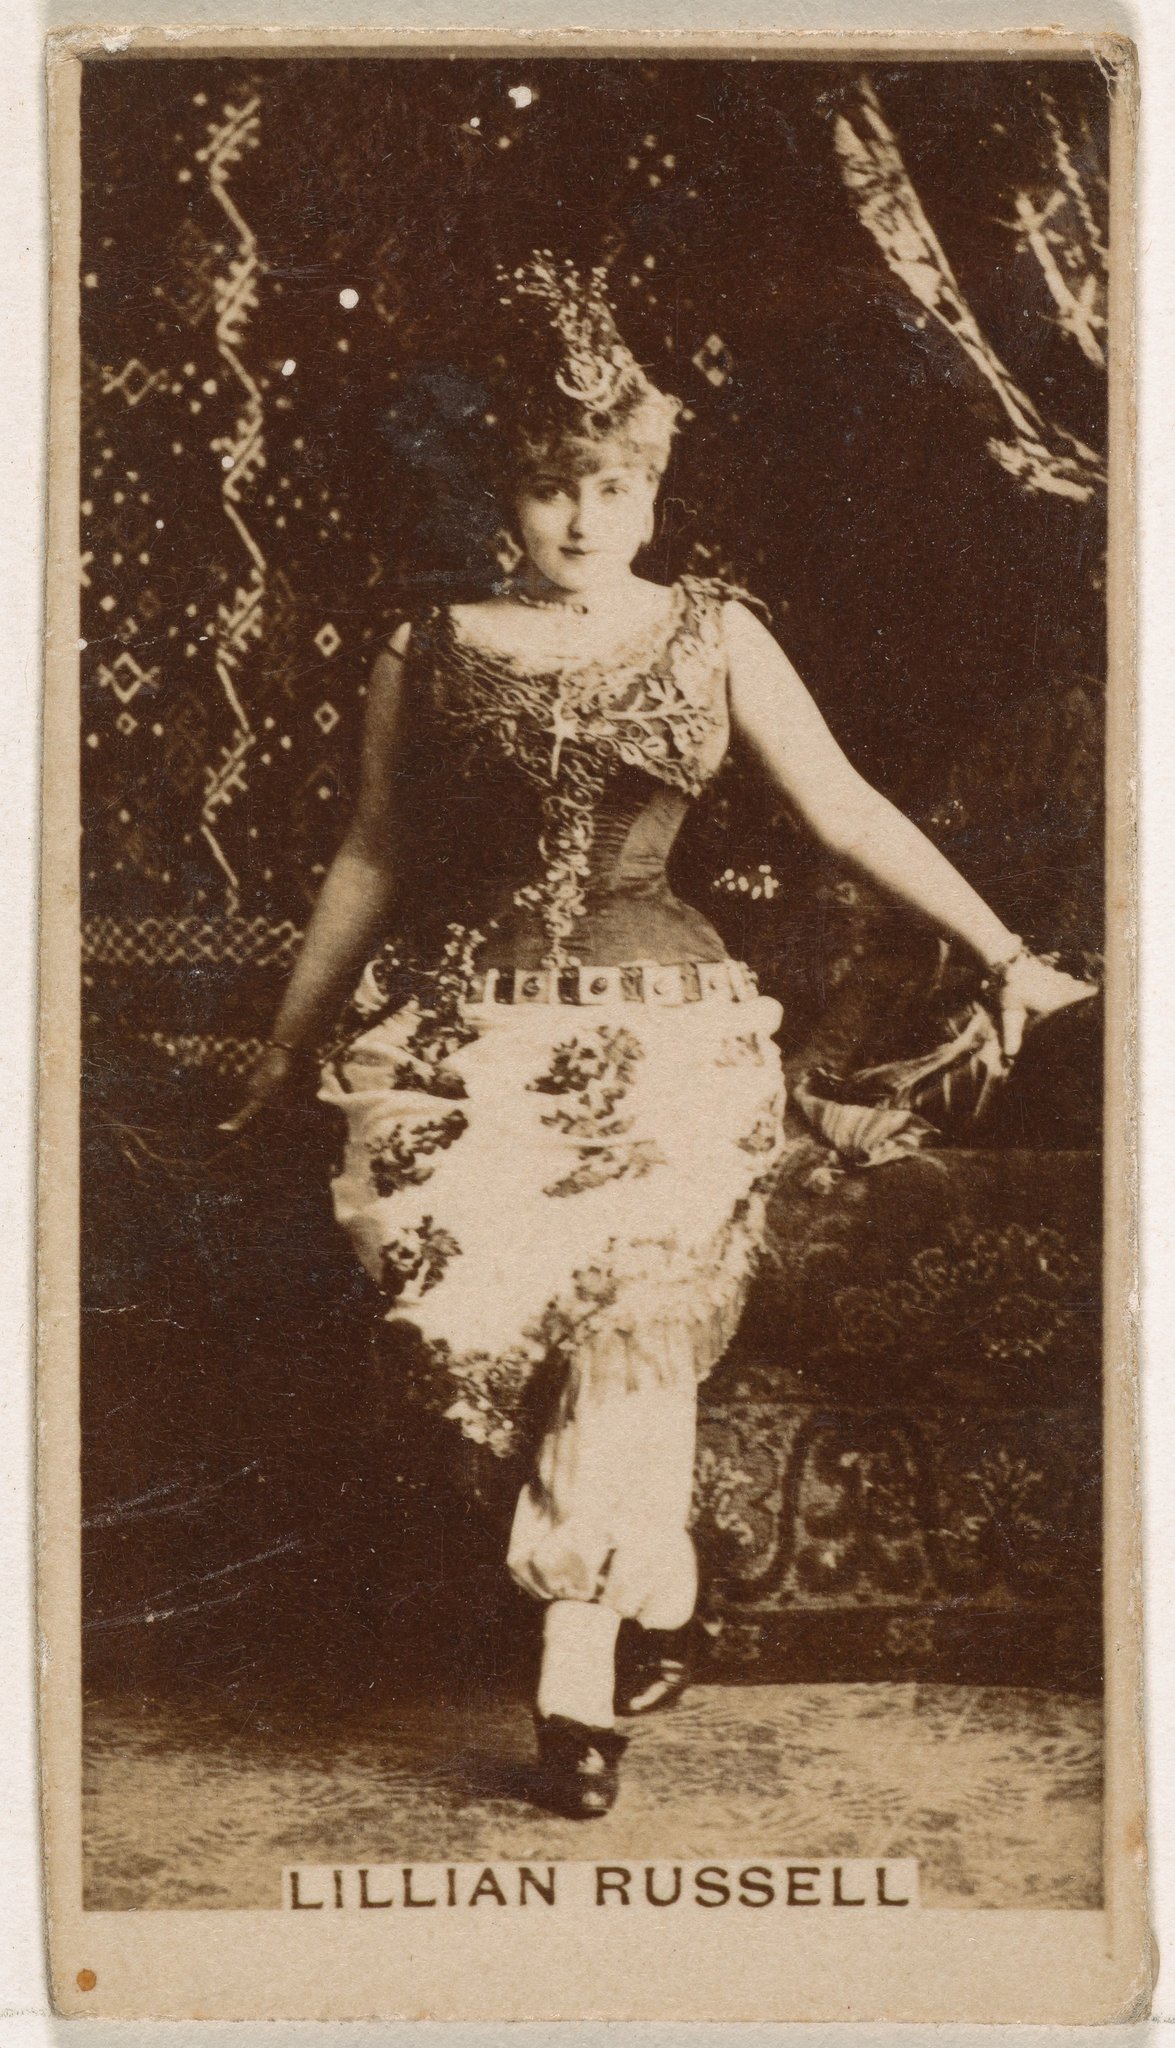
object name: photograph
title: Lillian Russell, from the Actresses series (N245) issued by Kinney Brothers to promote Sweet Caporal Cigarettes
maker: kinney brothers tobacco company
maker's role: publisher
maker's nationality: american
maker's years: 1869-2011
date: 1890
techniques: albumen silver print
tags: portraits,women,actresses